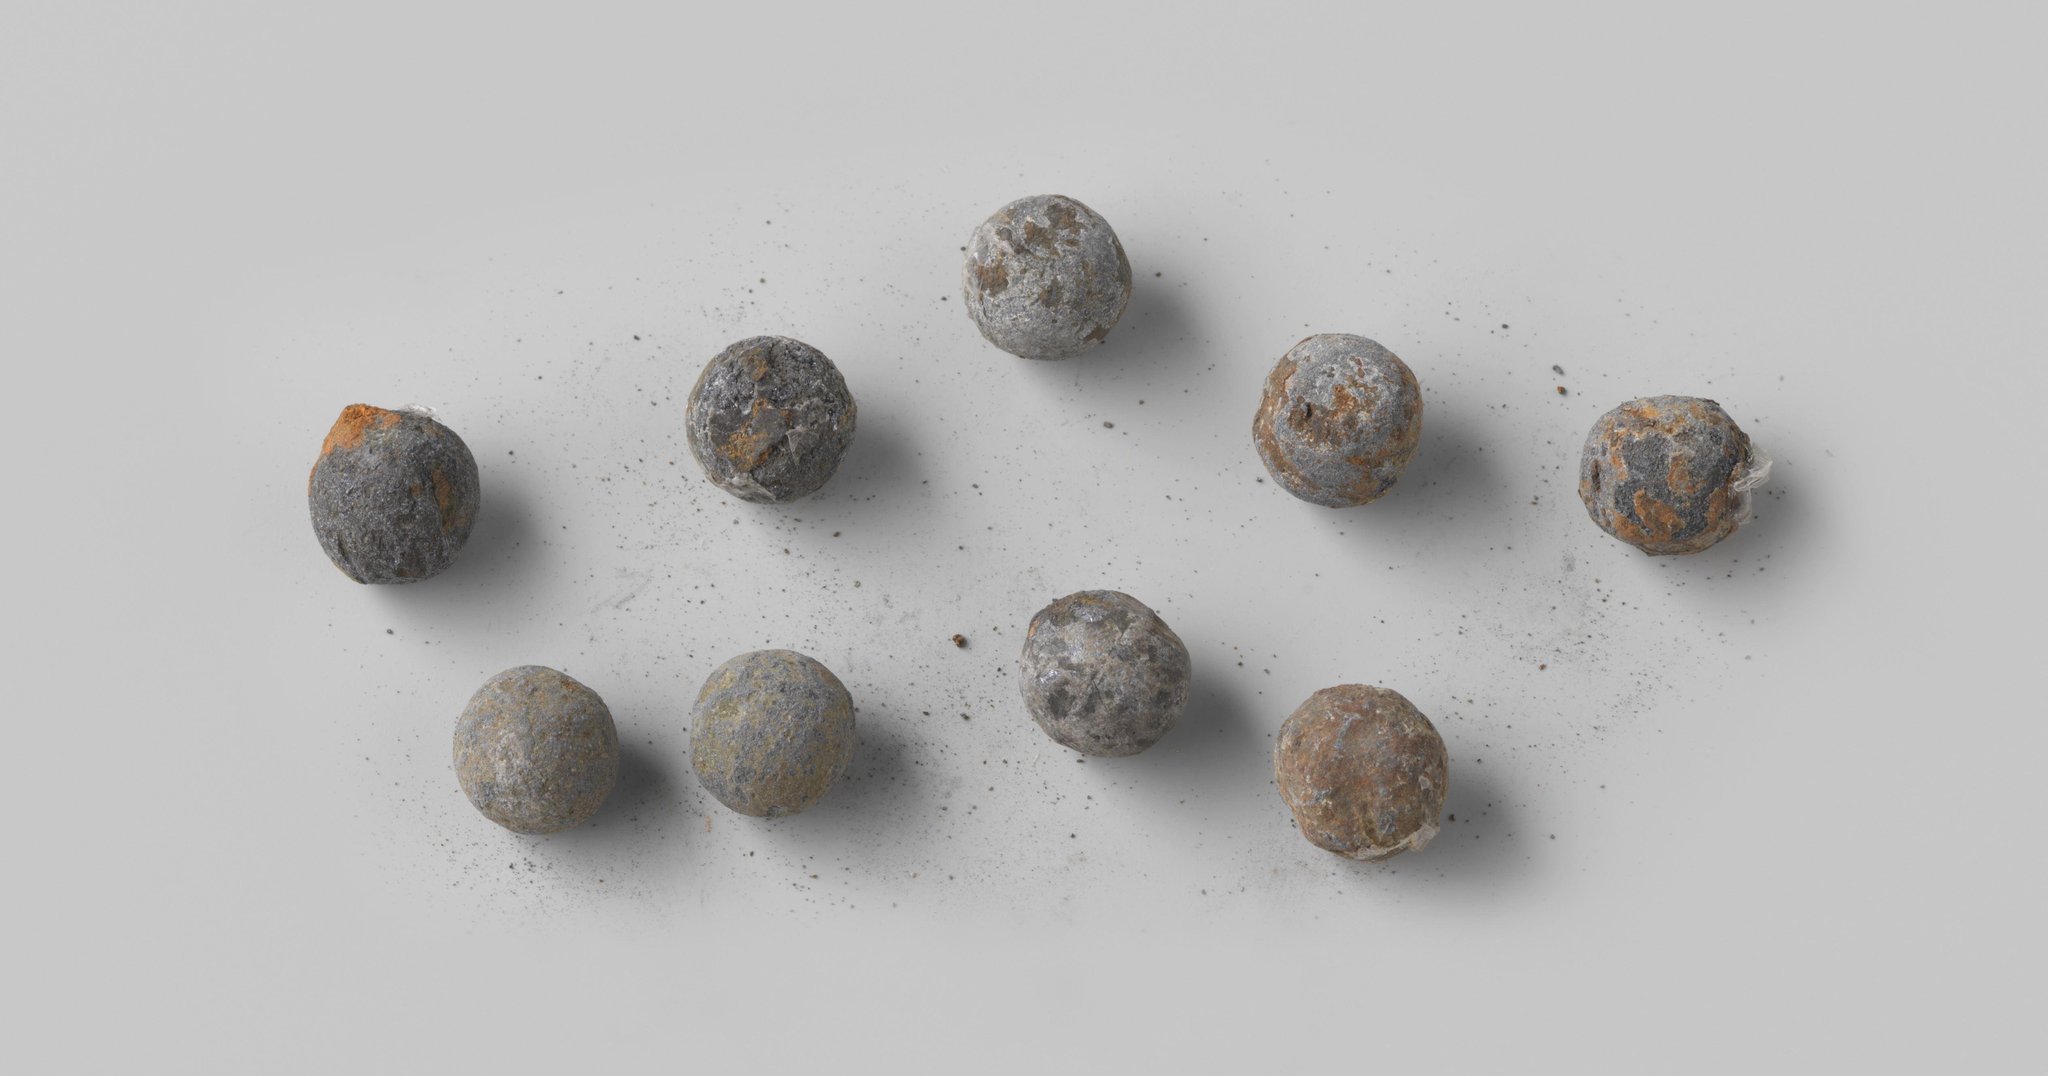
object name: bullet ammunition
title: Pistoolkogels uit het wrak van de Oost-Indiëvaarder Meresteijn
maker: Anonymous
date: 1693-1702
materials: lead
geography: netherlands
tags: cape of good hope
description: Negen loden pistoolkogels, bolvormige massive ballen, gecorrodeerd, enkele met aankoekingen. Shot, pistol.